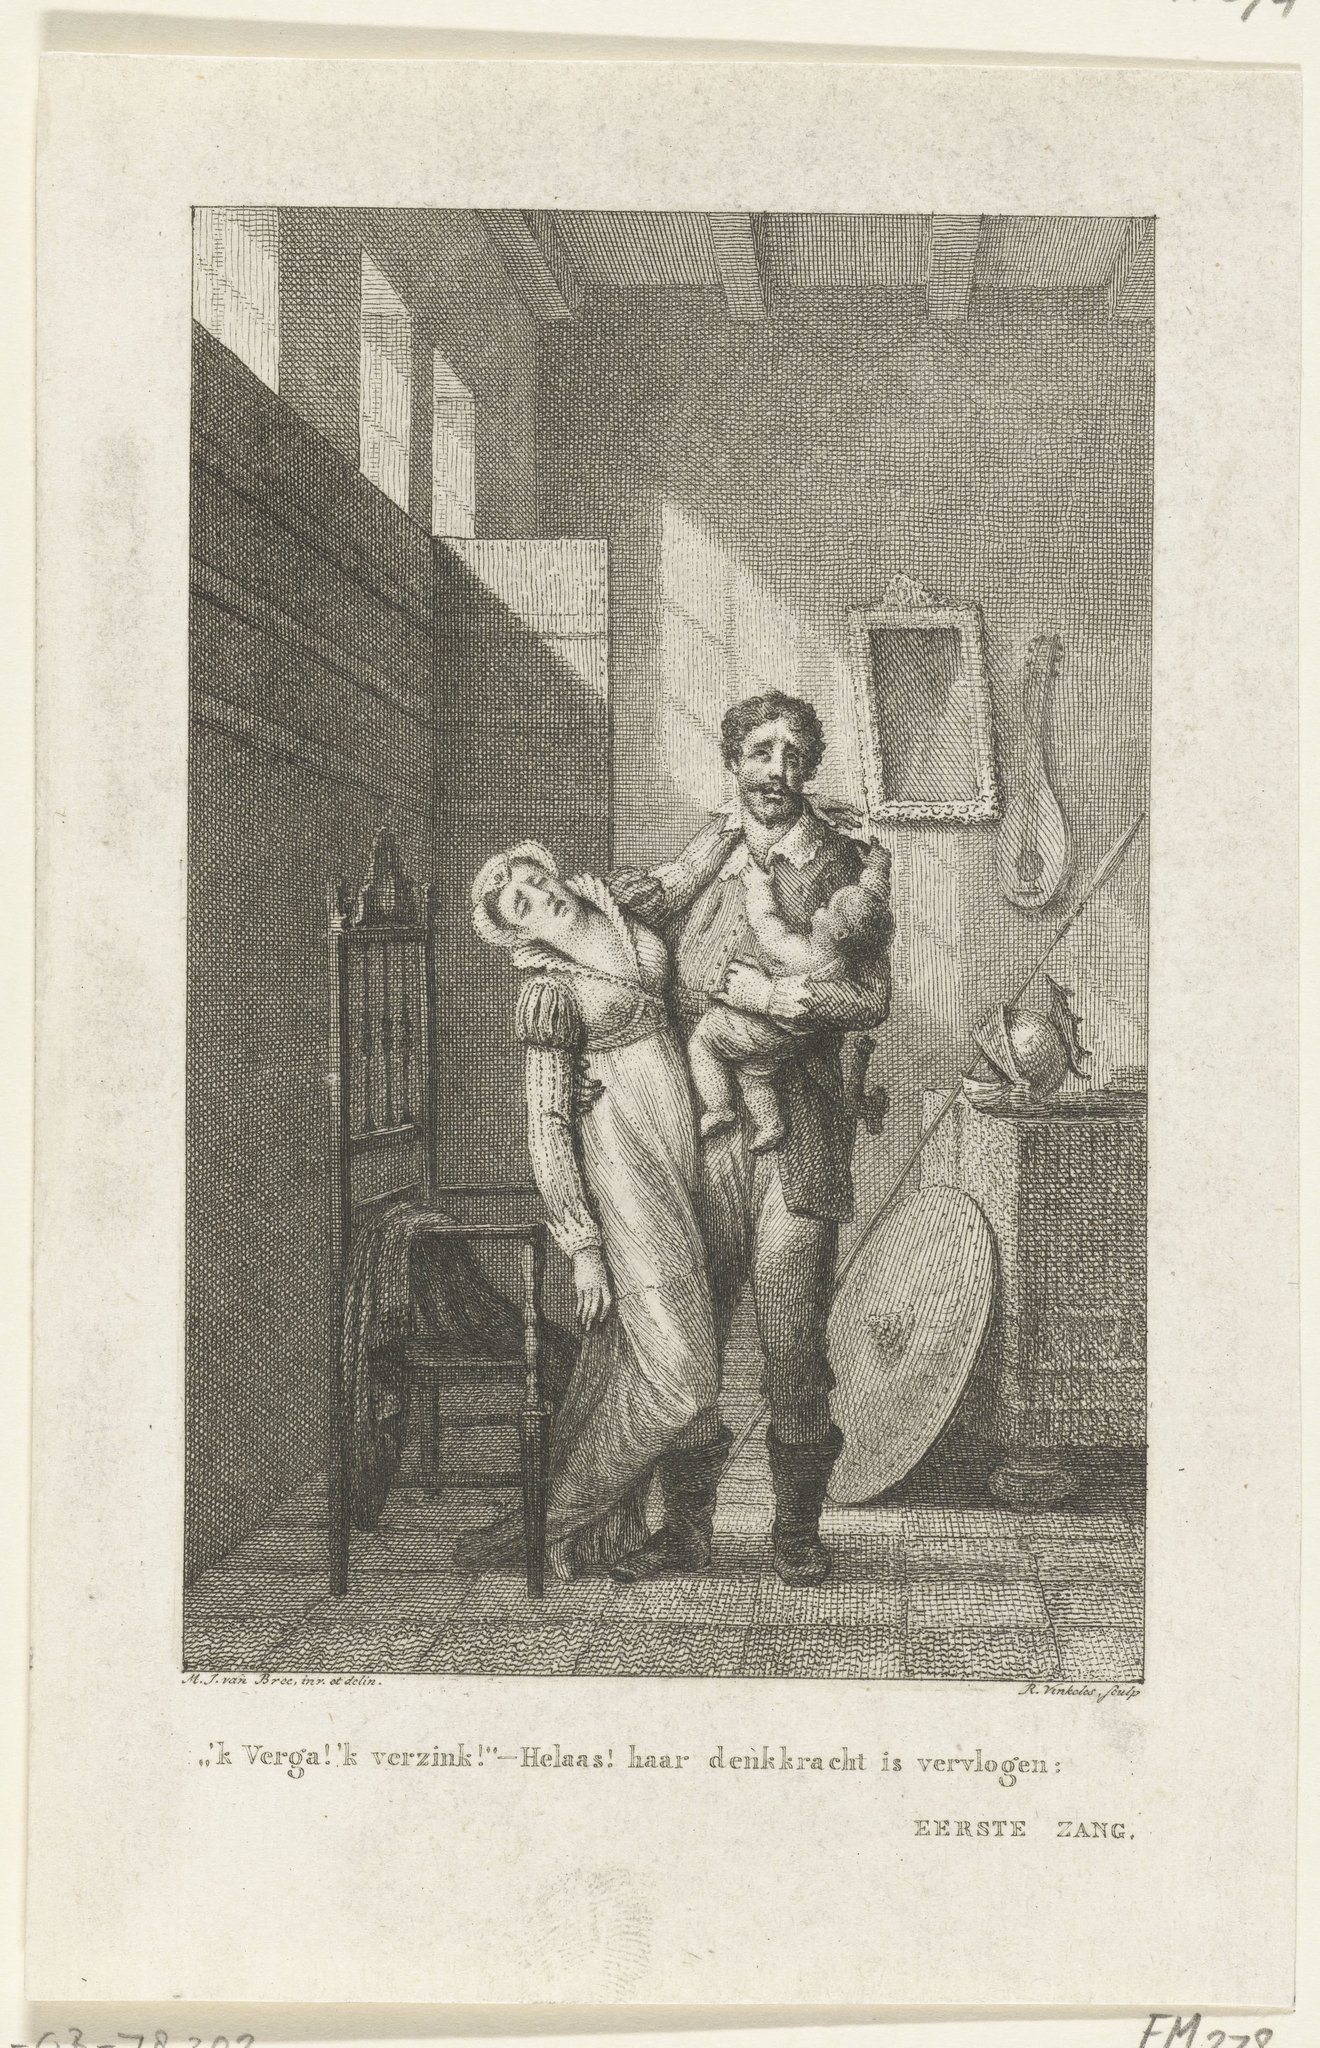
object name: print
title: Albrecht Beiling neemt afscheid van vrouw en kind, 1426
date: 1842-1844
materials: paper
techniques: engraving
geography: netherlands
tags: jacoba of bavaria (countess of hainaut), netherlands, burgundian netherlands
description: Albrecht Beiling, bevelhebber in Schoonhoven, door Jacoba van Beieren veroordeeld om levend begraven te worden, neemt afscheid van vrouw en kind, januari 1426.